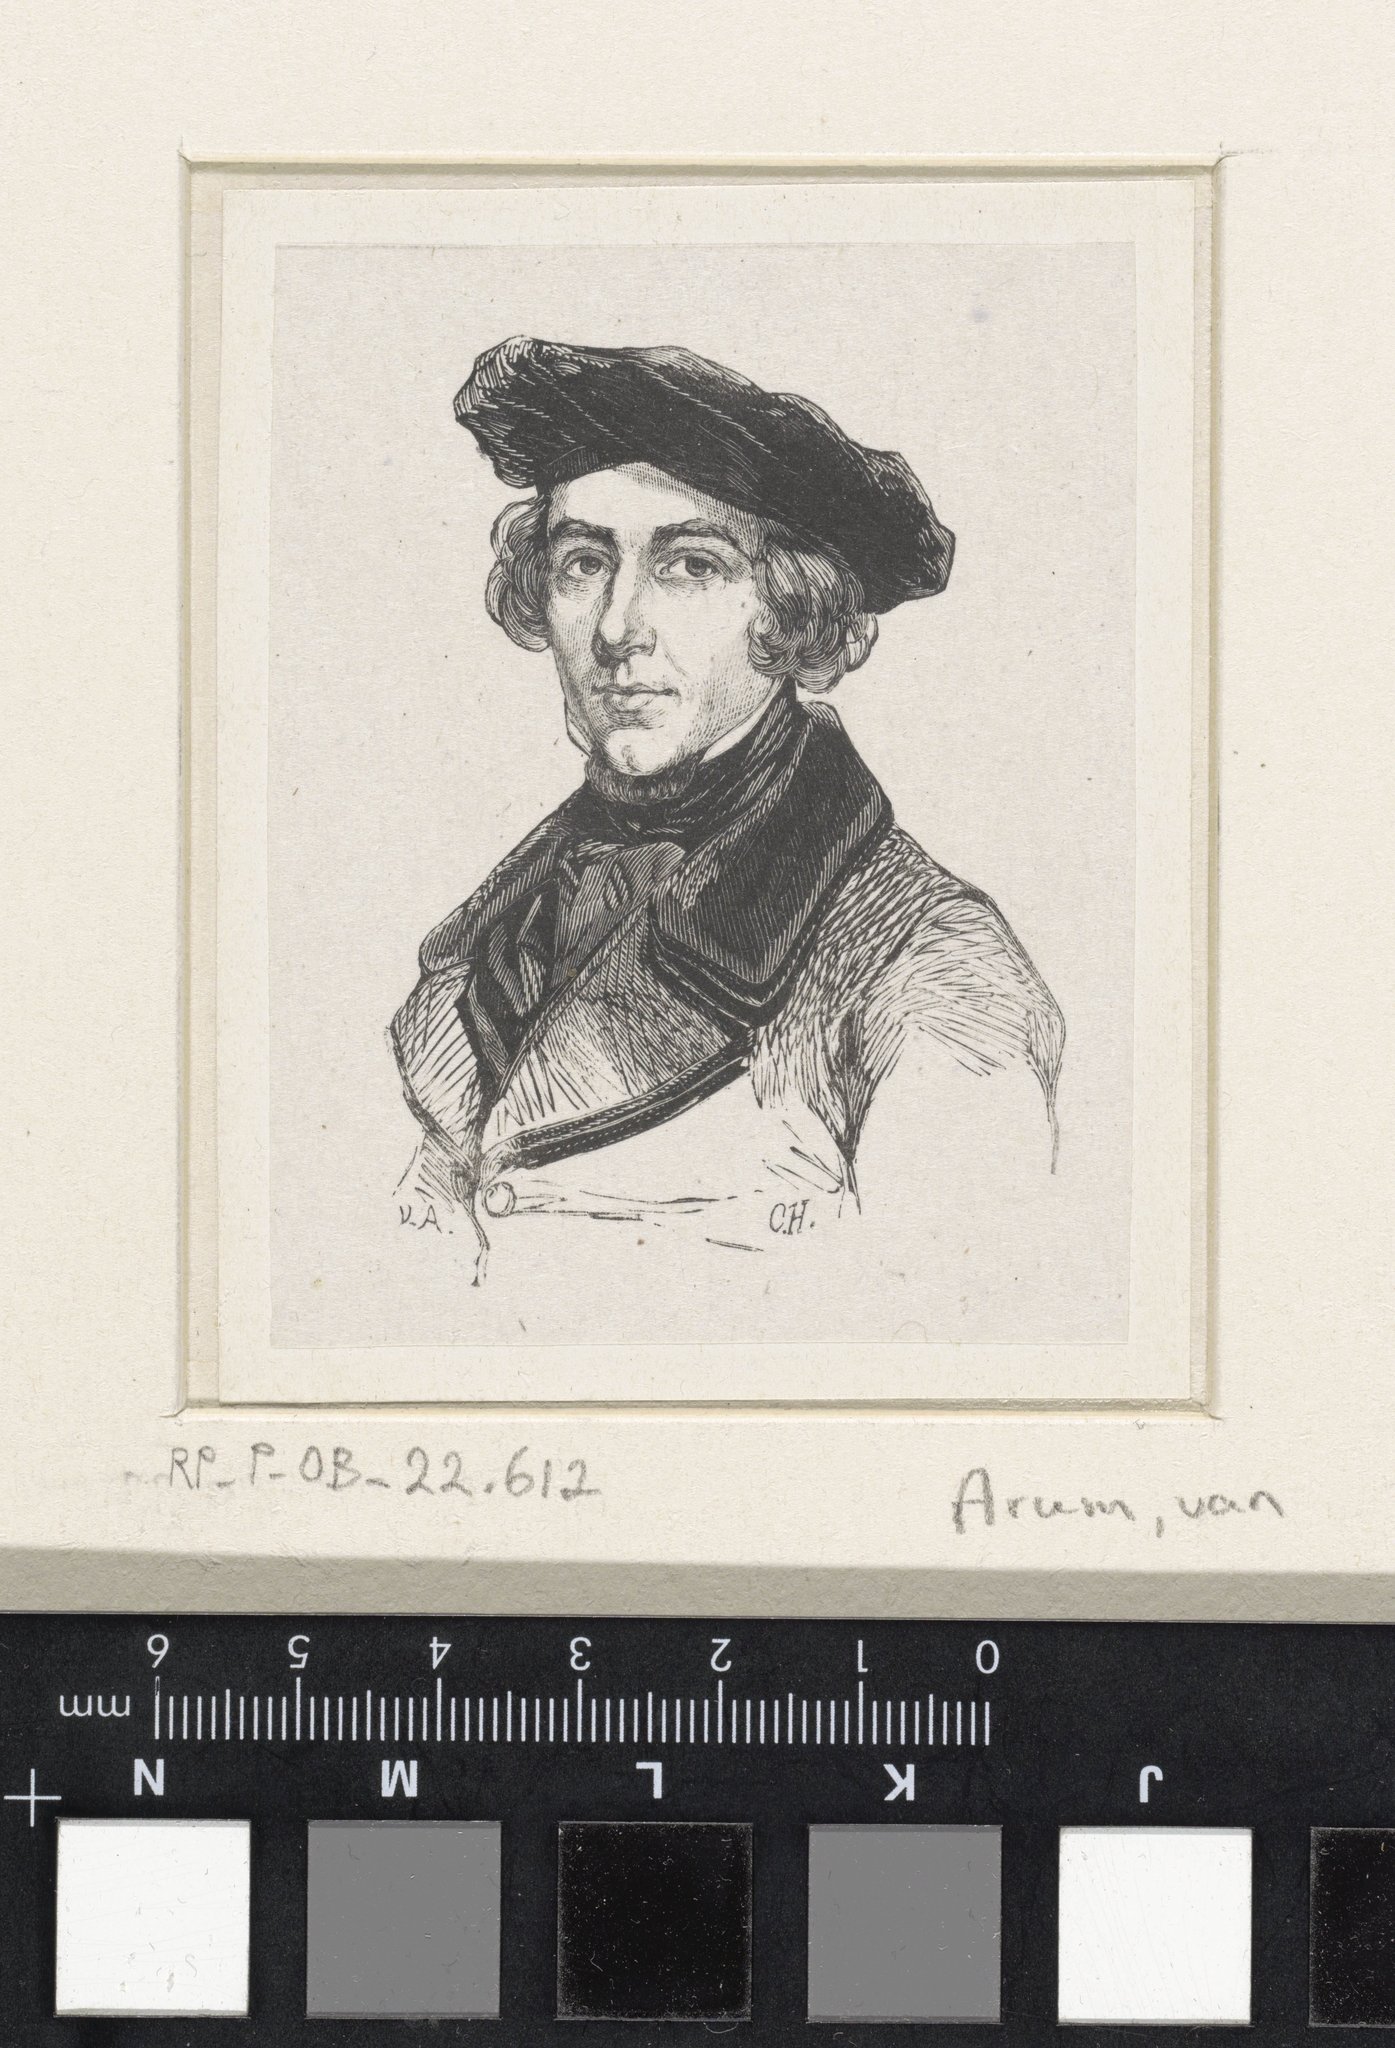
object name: print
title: Portret van de schilder Kasparus Karsen, met baret naar links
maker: van arum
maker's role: print maker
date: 1819-1921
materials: paper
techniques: engraving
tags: amsterdam, painter, draughtsman, kasparus karsen, historical persons, portrait, self-portrait of painter, portrait, self-portrait of artist